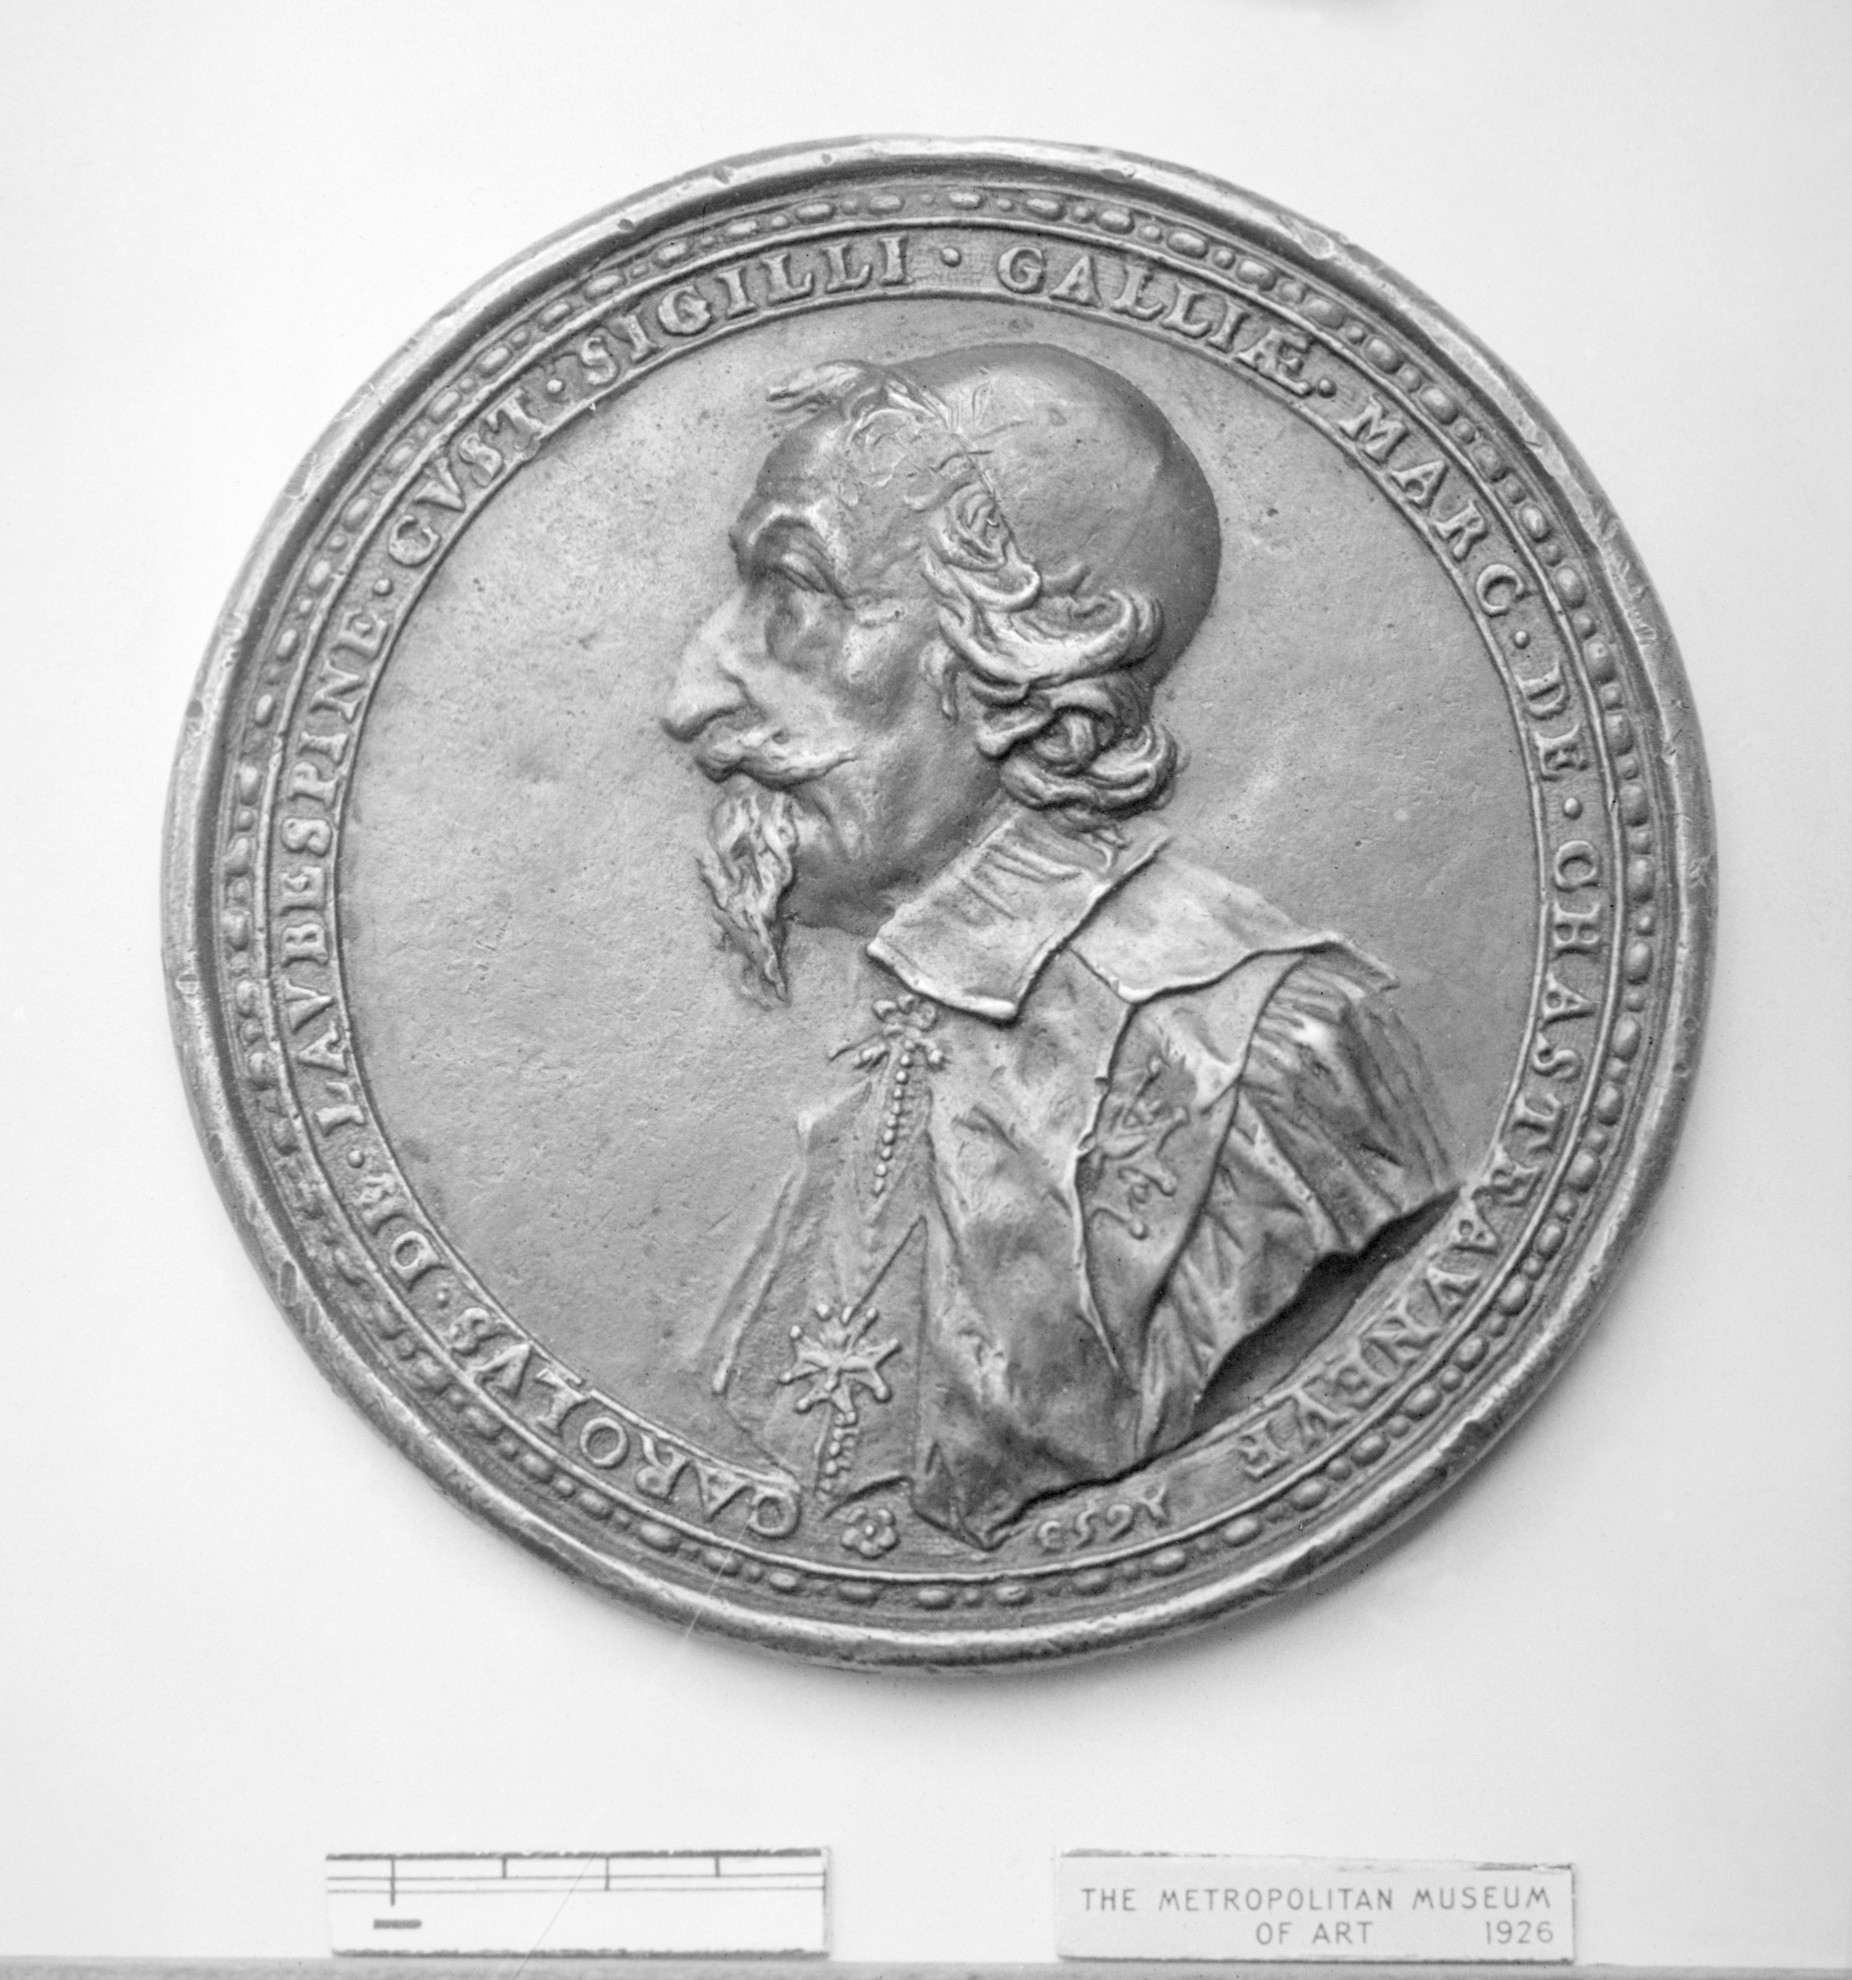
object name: medal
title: Charles de l'Aubespine, Marquis de Châteauneuf (1580–1653)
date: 1653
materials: bronze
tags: human figures,men,profiles,women